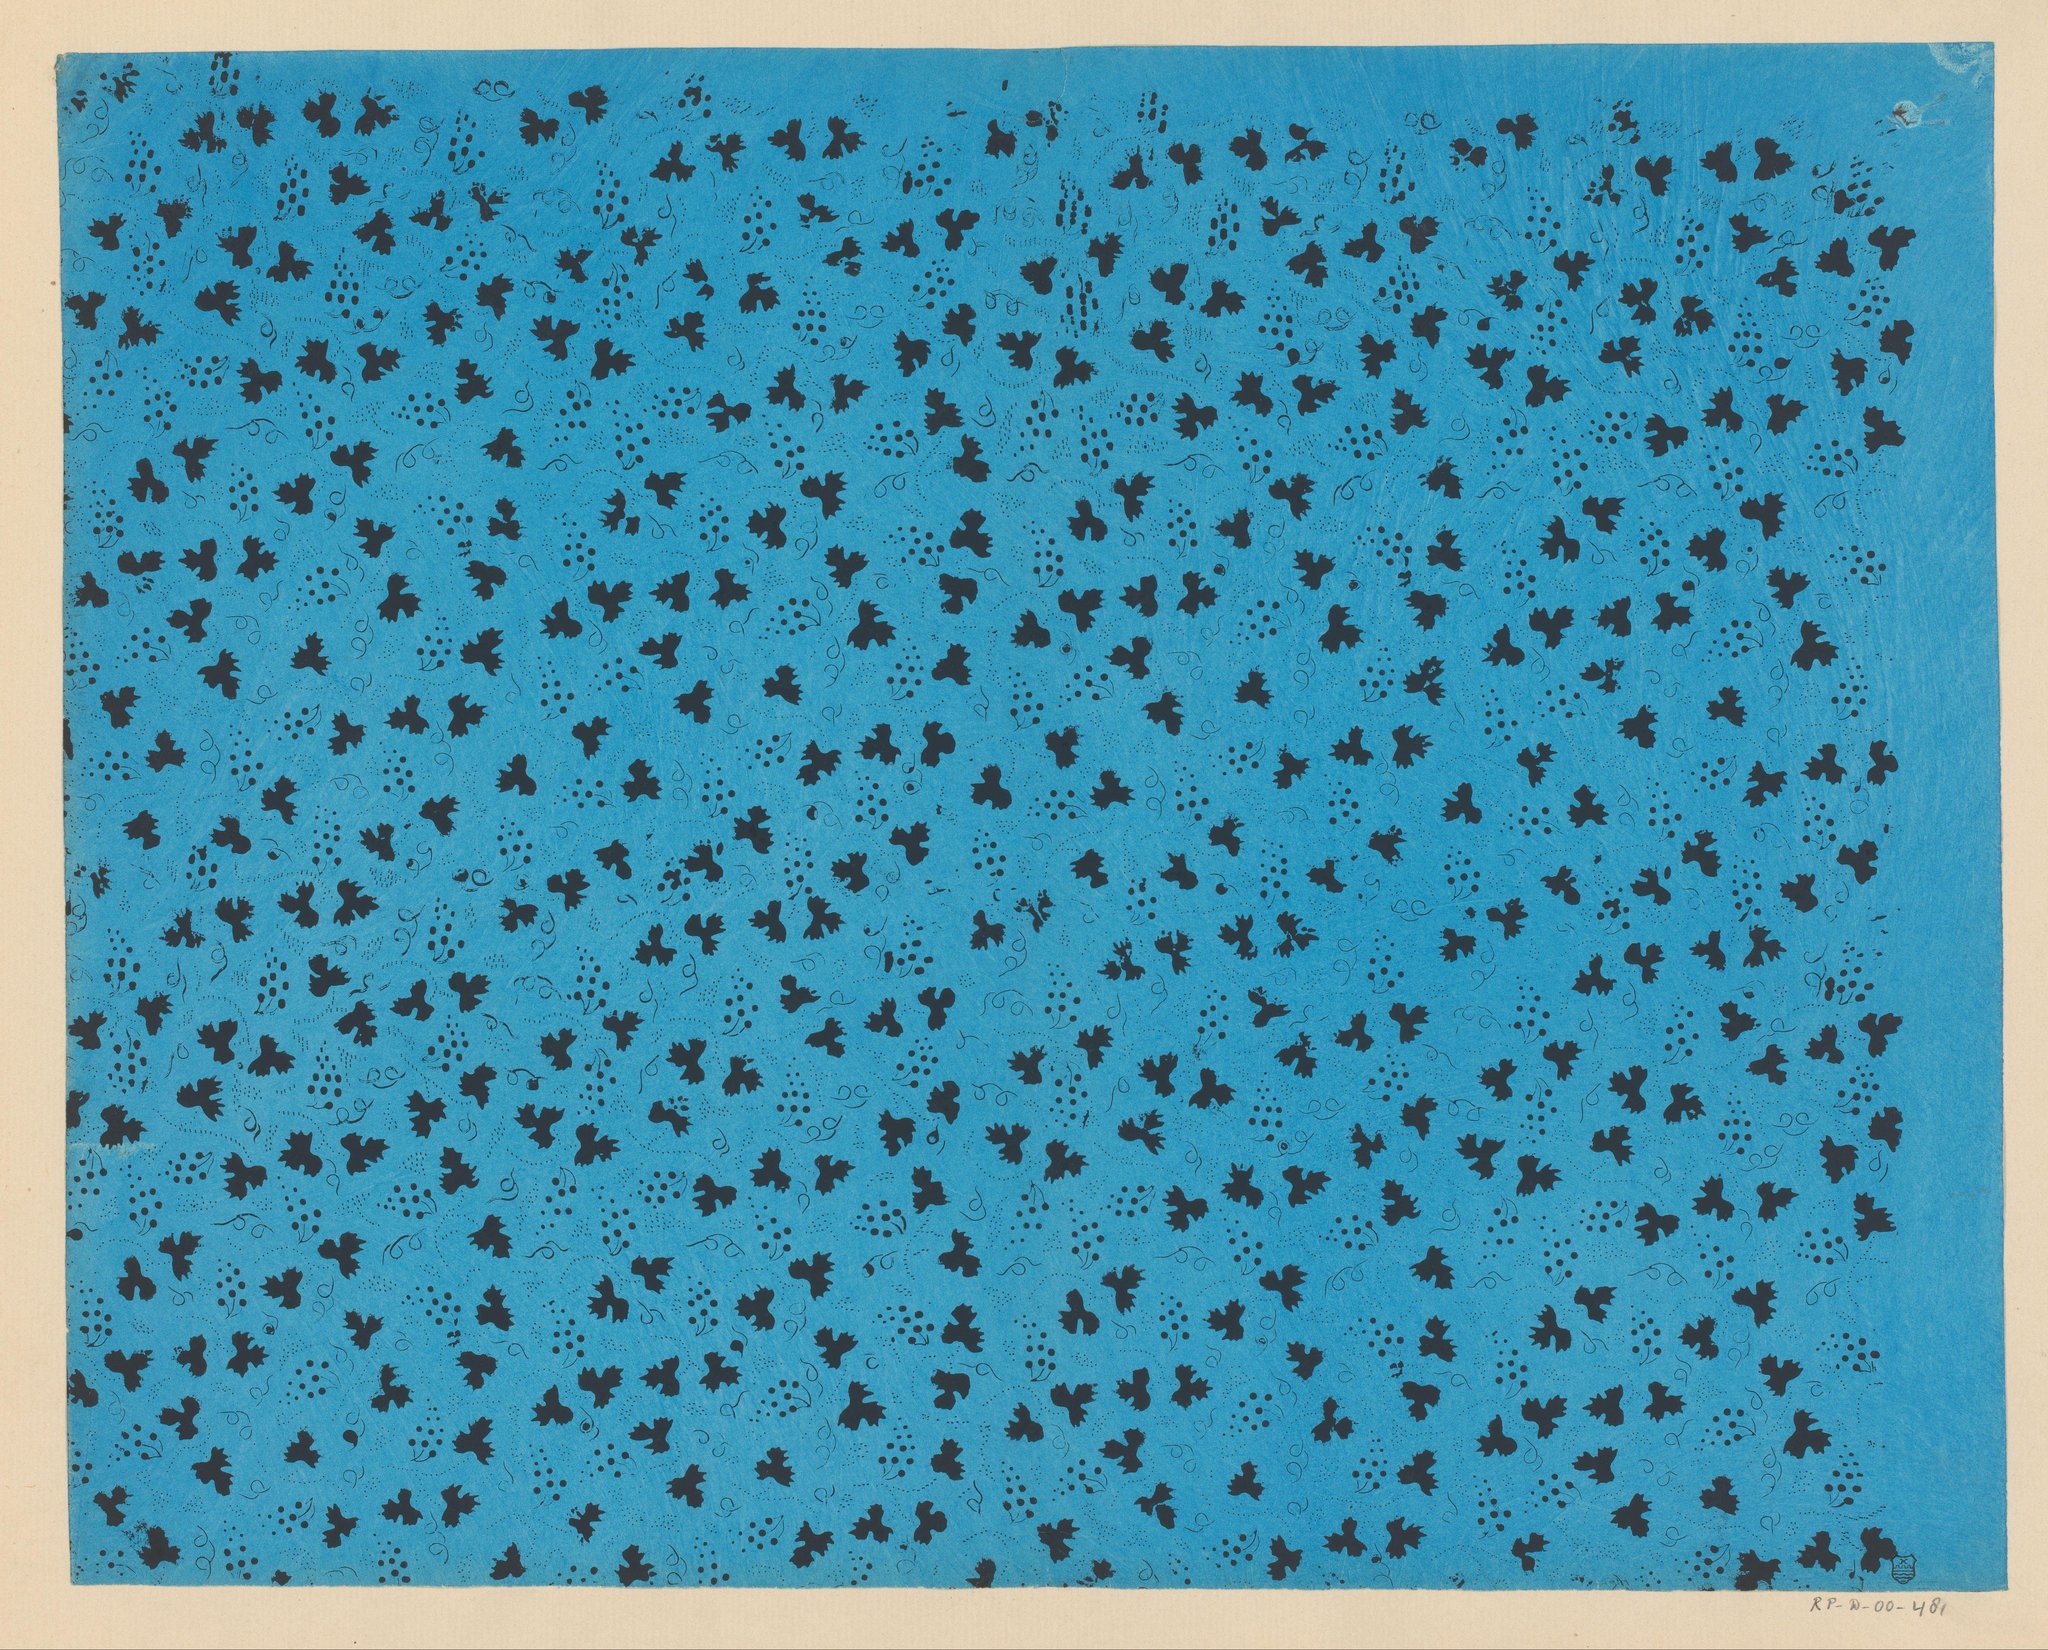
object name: printed paper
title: Blad met strooipatroon van bladmotief tussen rankje, vruchten en punten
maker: Anonymous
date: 1800-1900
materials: ink, paper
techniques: printing block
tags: ornament derived from plant forms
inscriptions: collector's mark: Lugt 2760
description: Blad met strooipatroon van bladmotief tussen rankje, vruchten en punten.